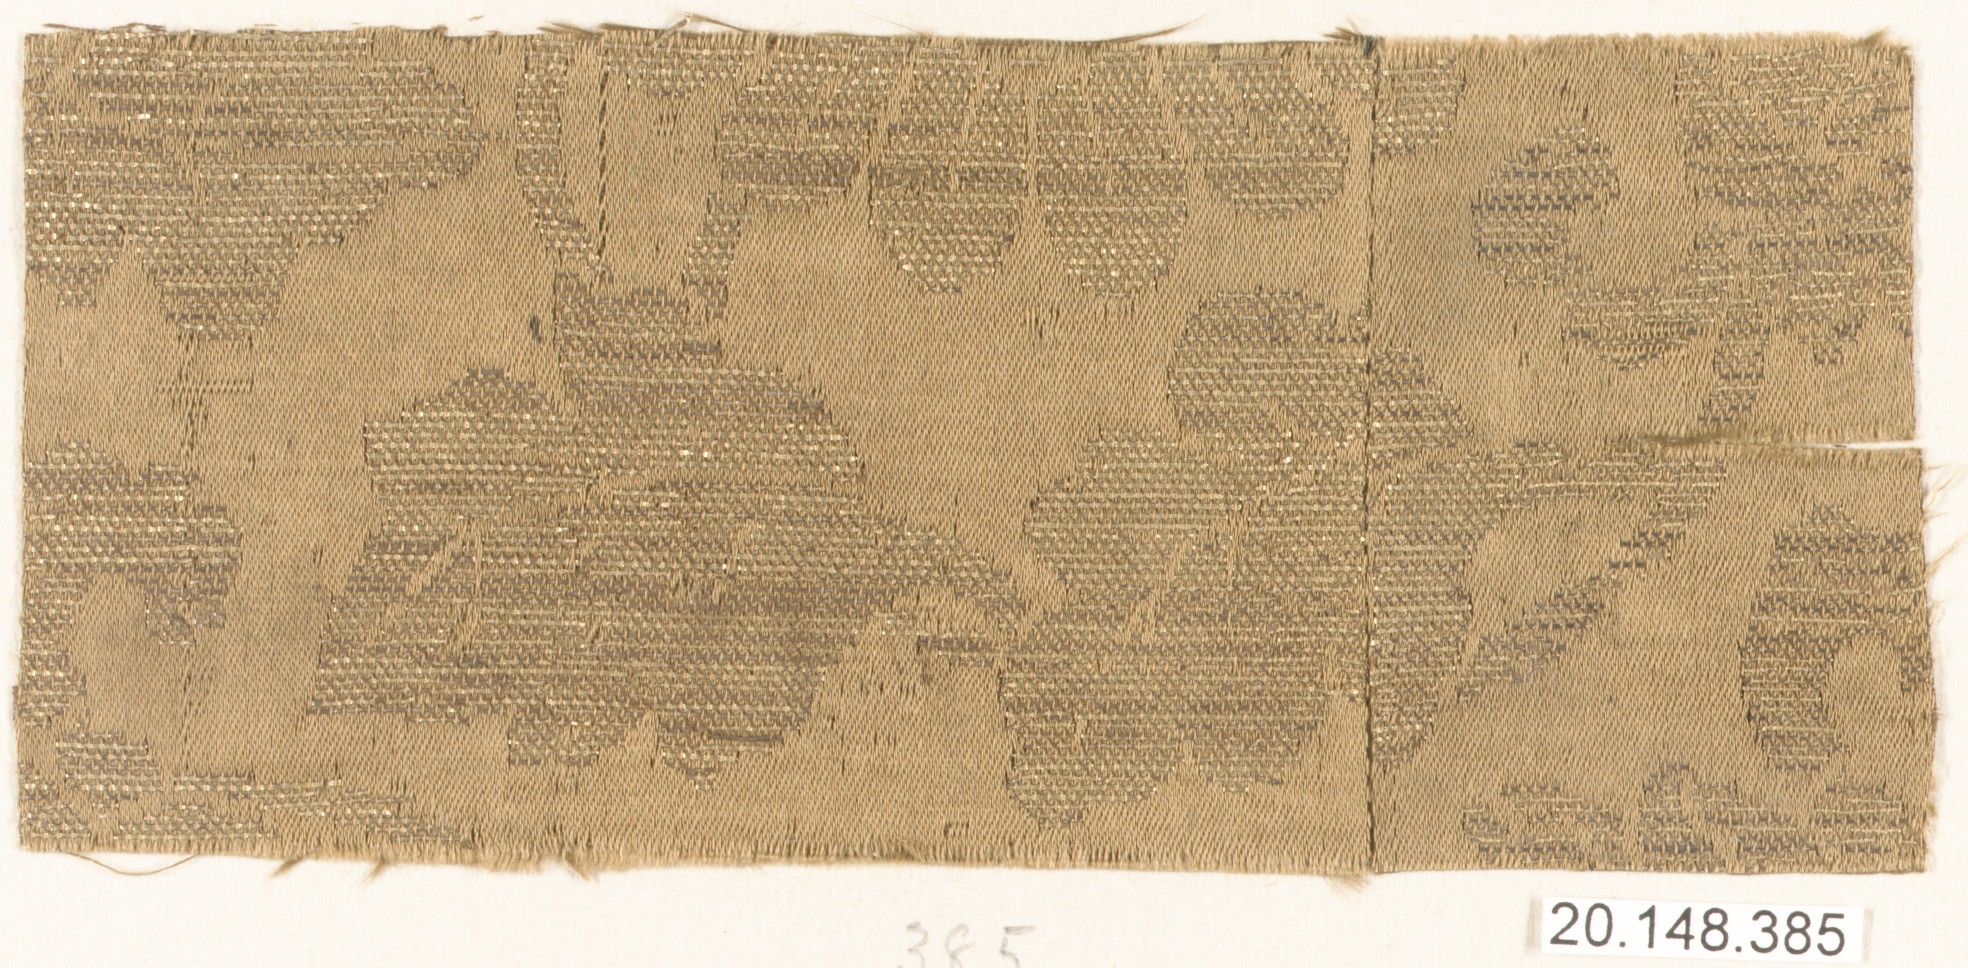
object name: piece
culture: japanese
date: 1701-1800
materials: silk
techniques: compound weave